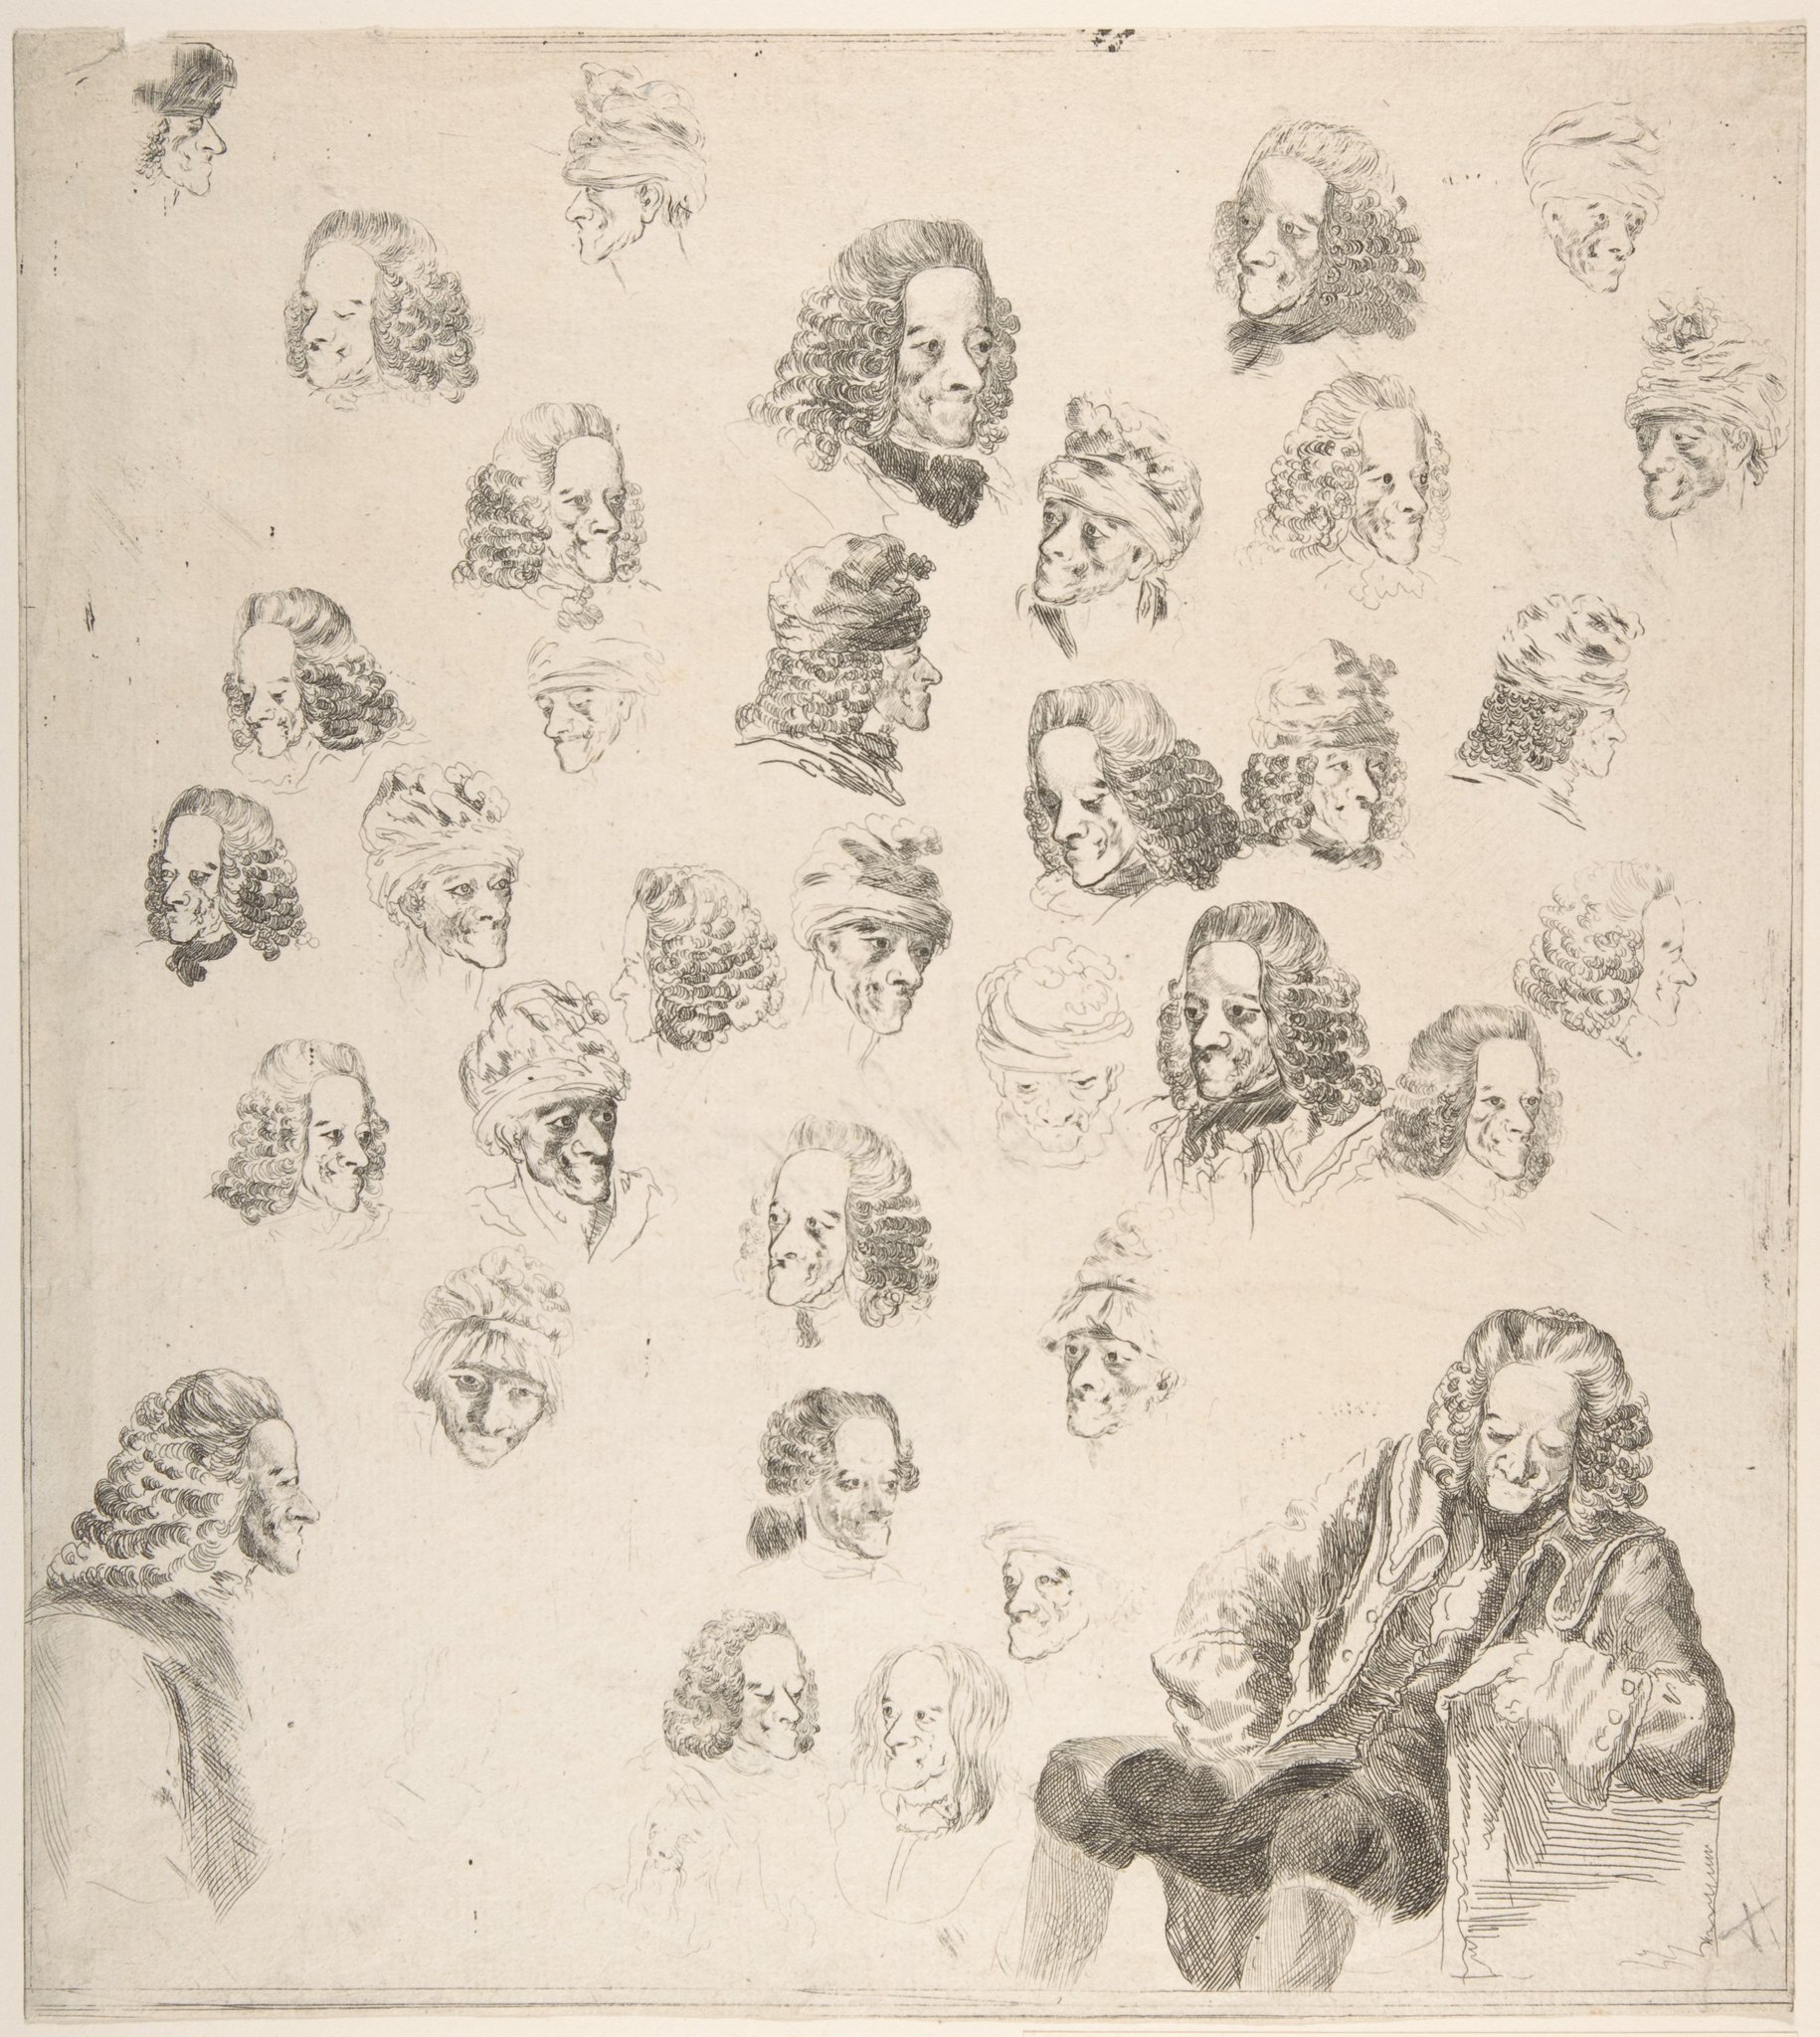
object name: print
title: Sketches of Voltaire at Age Eighty-One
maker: baron dominique vivant denon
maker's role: artist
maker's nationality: french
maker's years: 1747-1825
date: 1775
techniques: etching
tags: faces,men